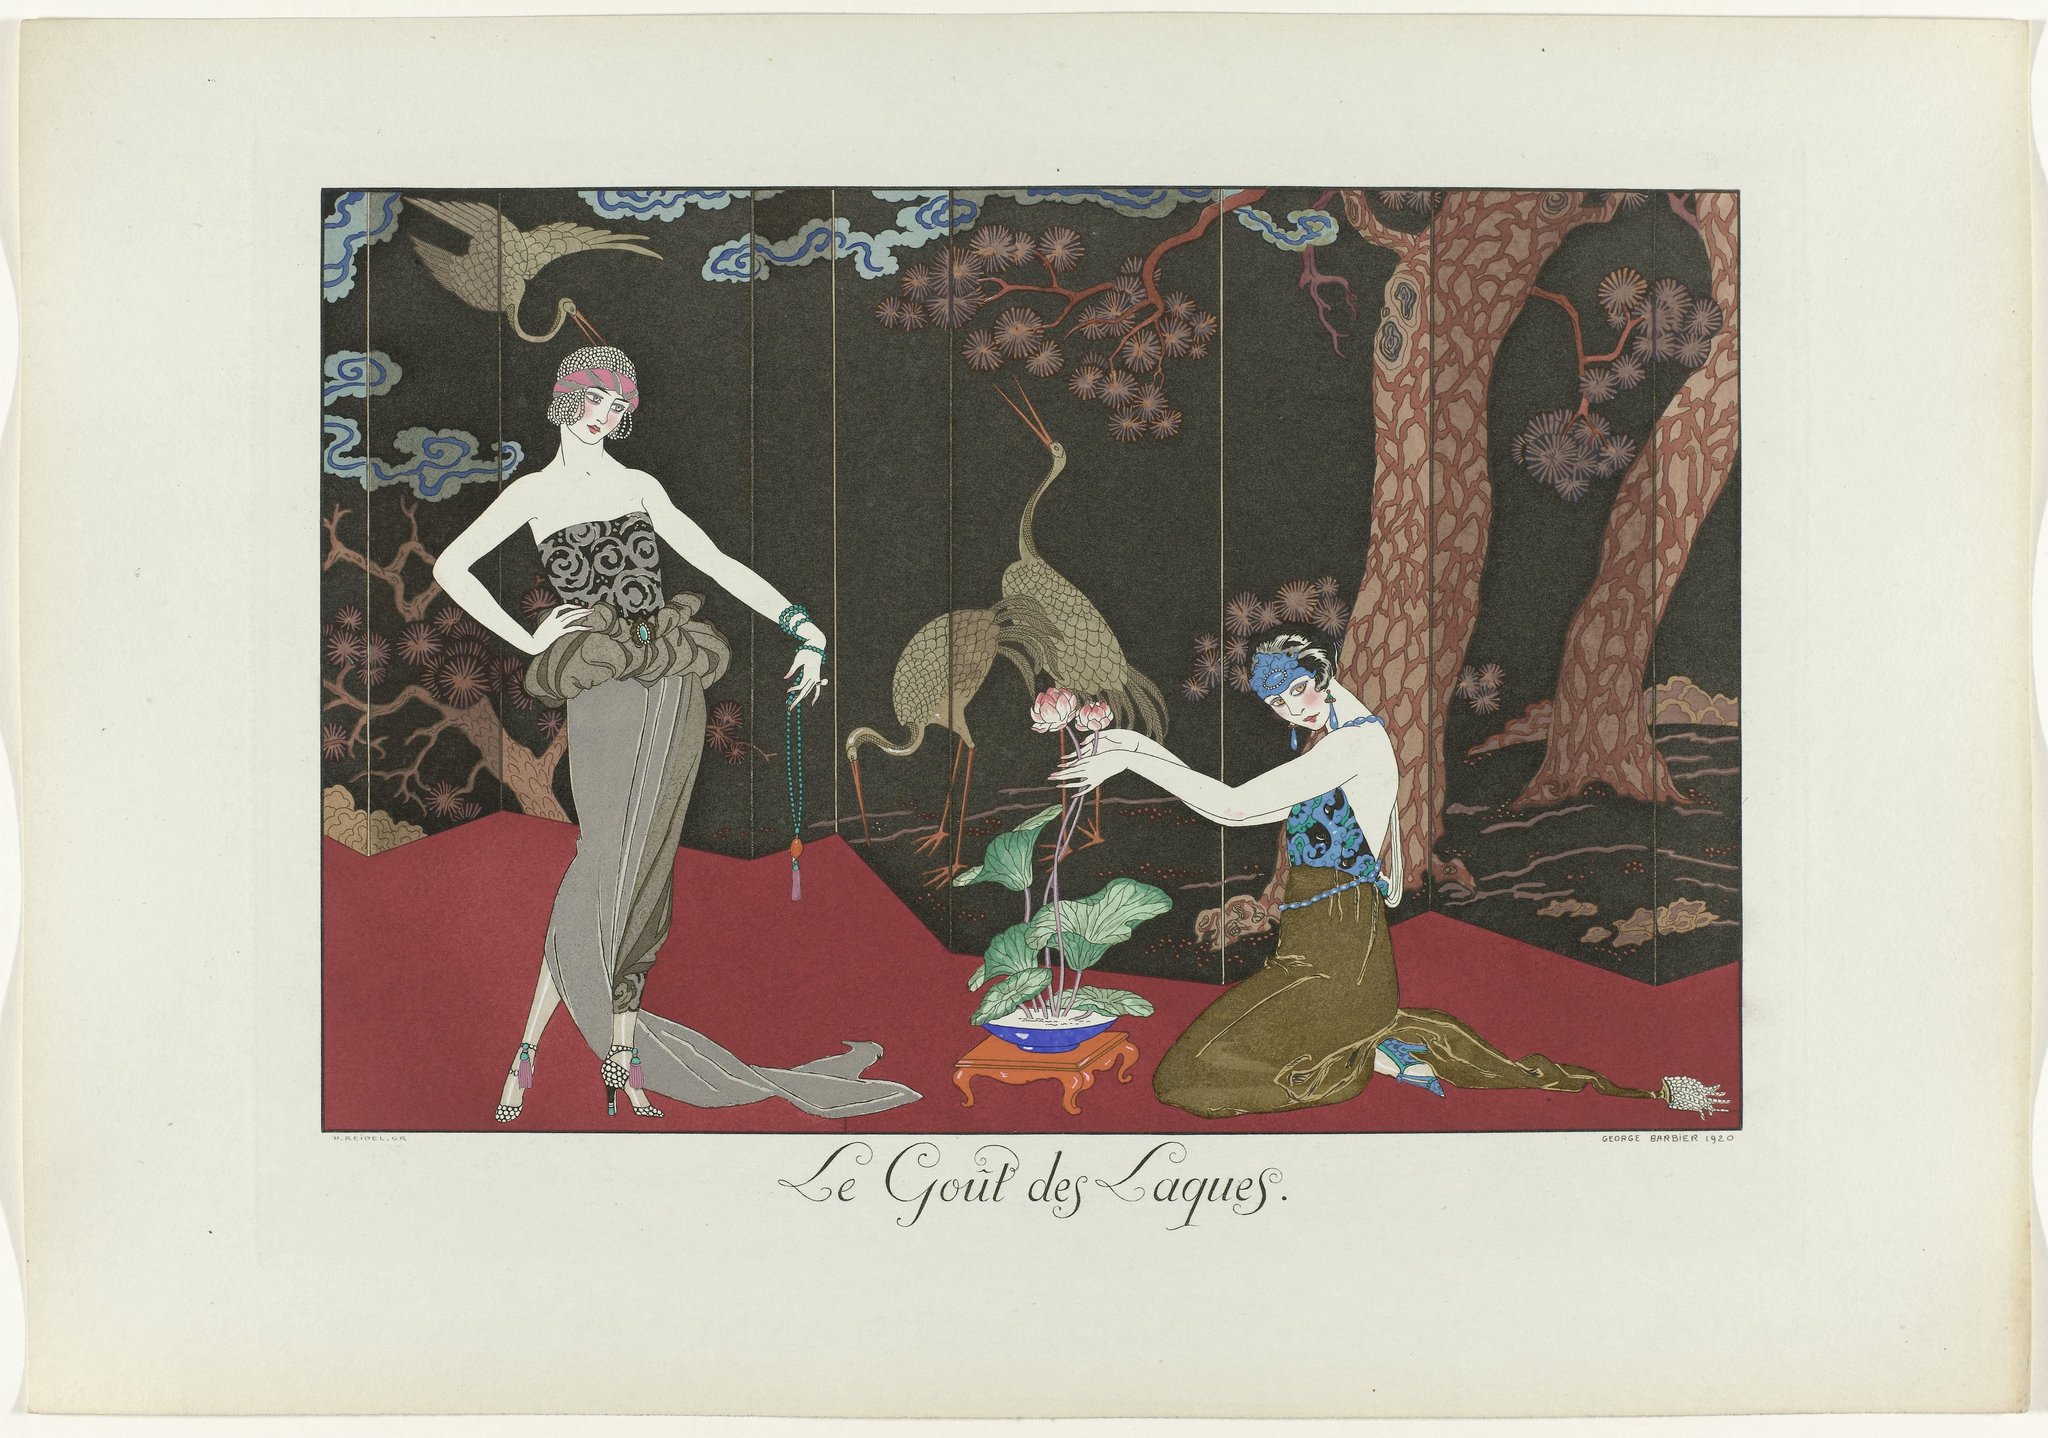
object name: fashion print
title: Le Bonheur du Jour ou Les Graces à la Mode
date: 1920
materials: paper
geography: paris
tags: fashion plates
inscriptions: date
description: Uit serie Le Bonheur du Jour ou Les Graces à la Mode.